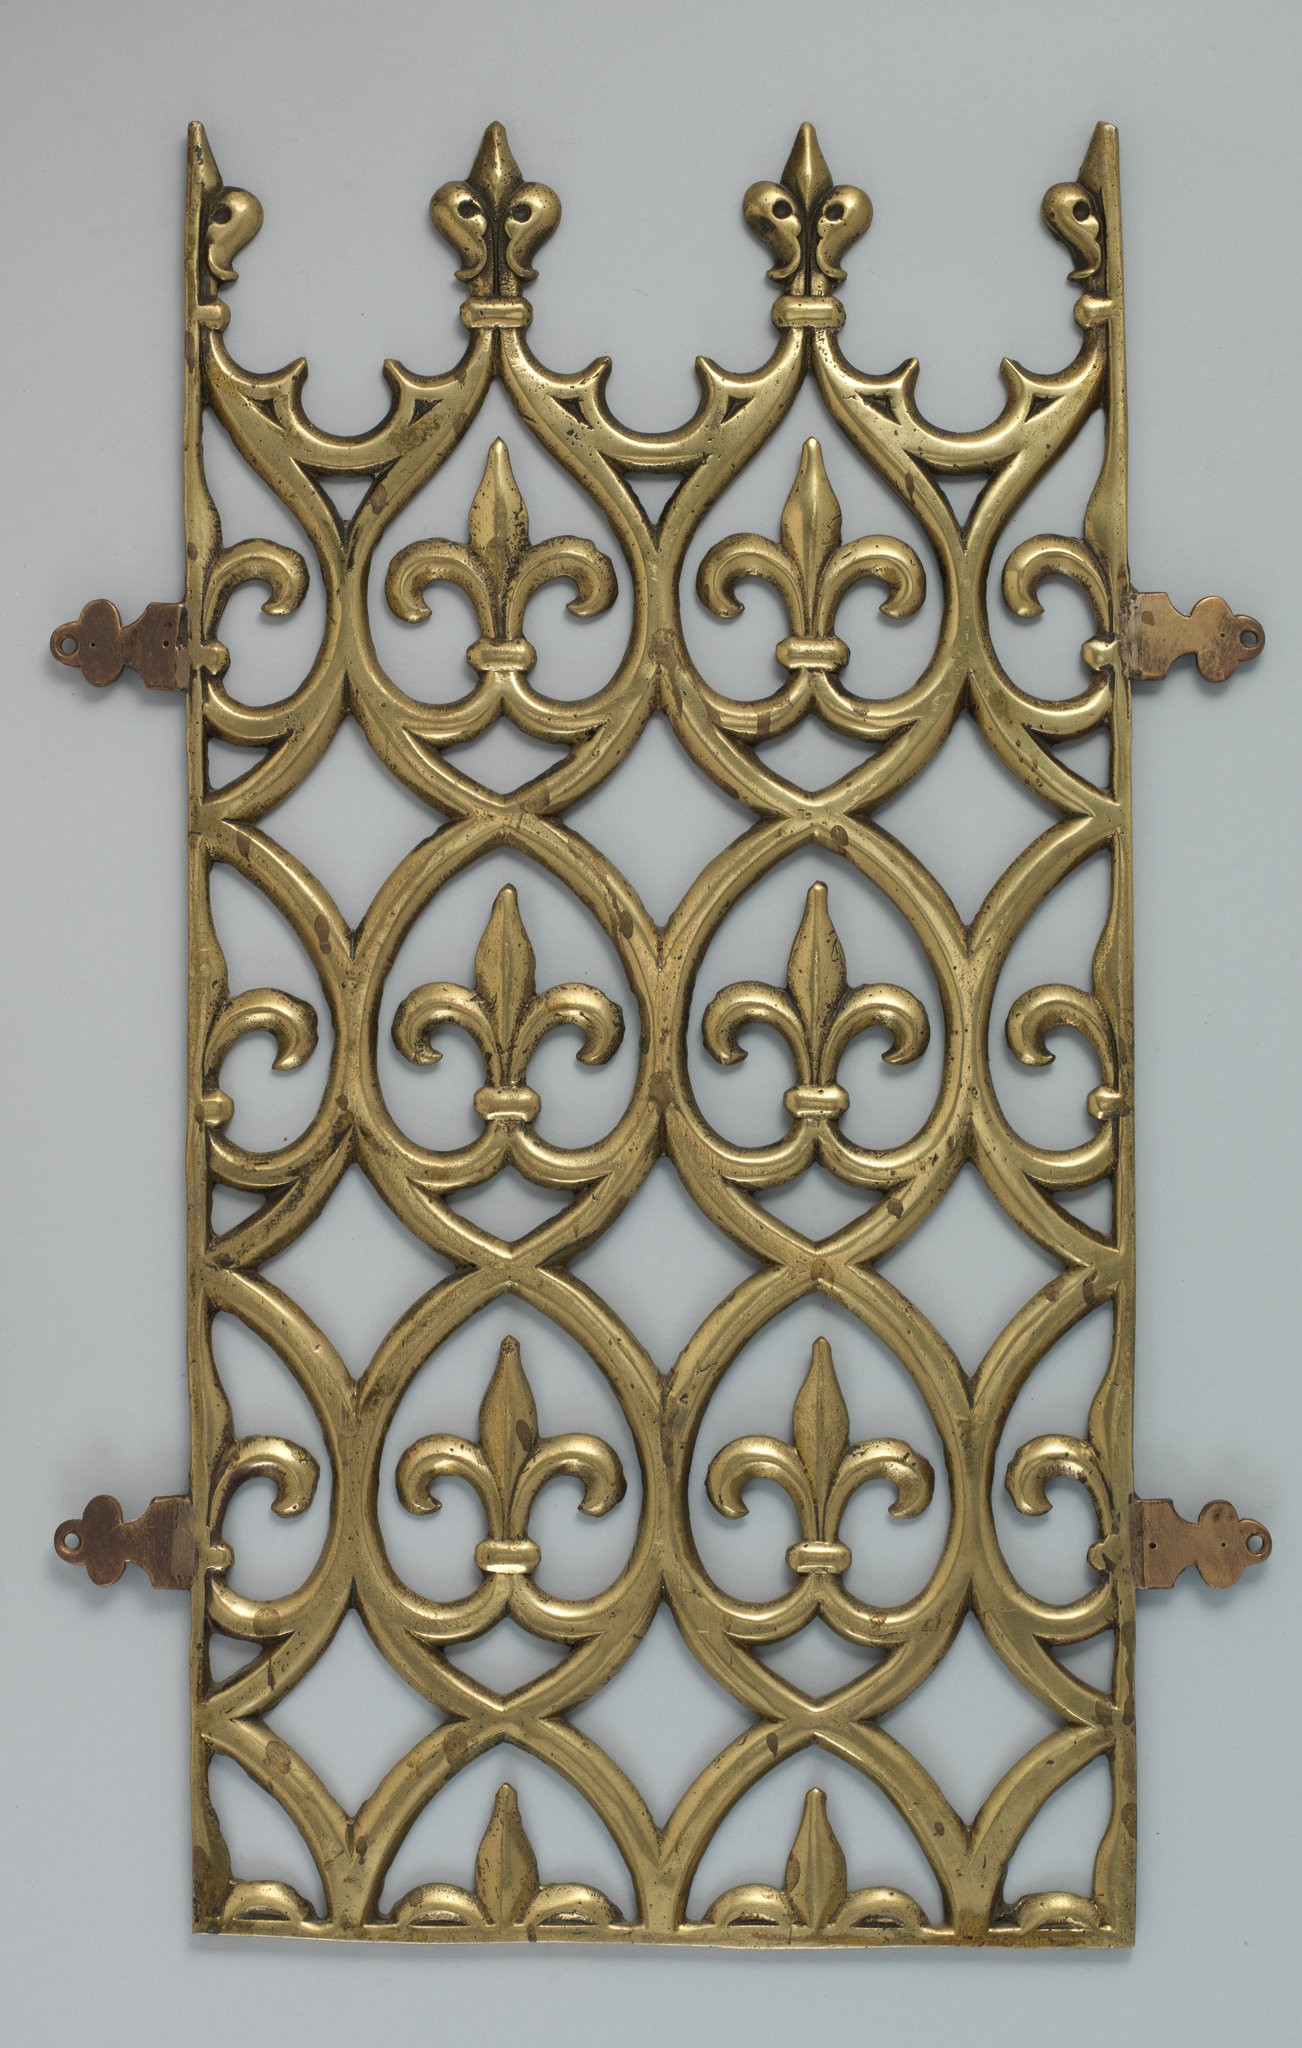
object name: grill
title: Decorative grill from the Palace of Westminster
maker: augustus welby northmore pugin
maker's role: designer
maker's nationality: british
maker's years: 1812-1852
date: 1845-1859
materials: brass